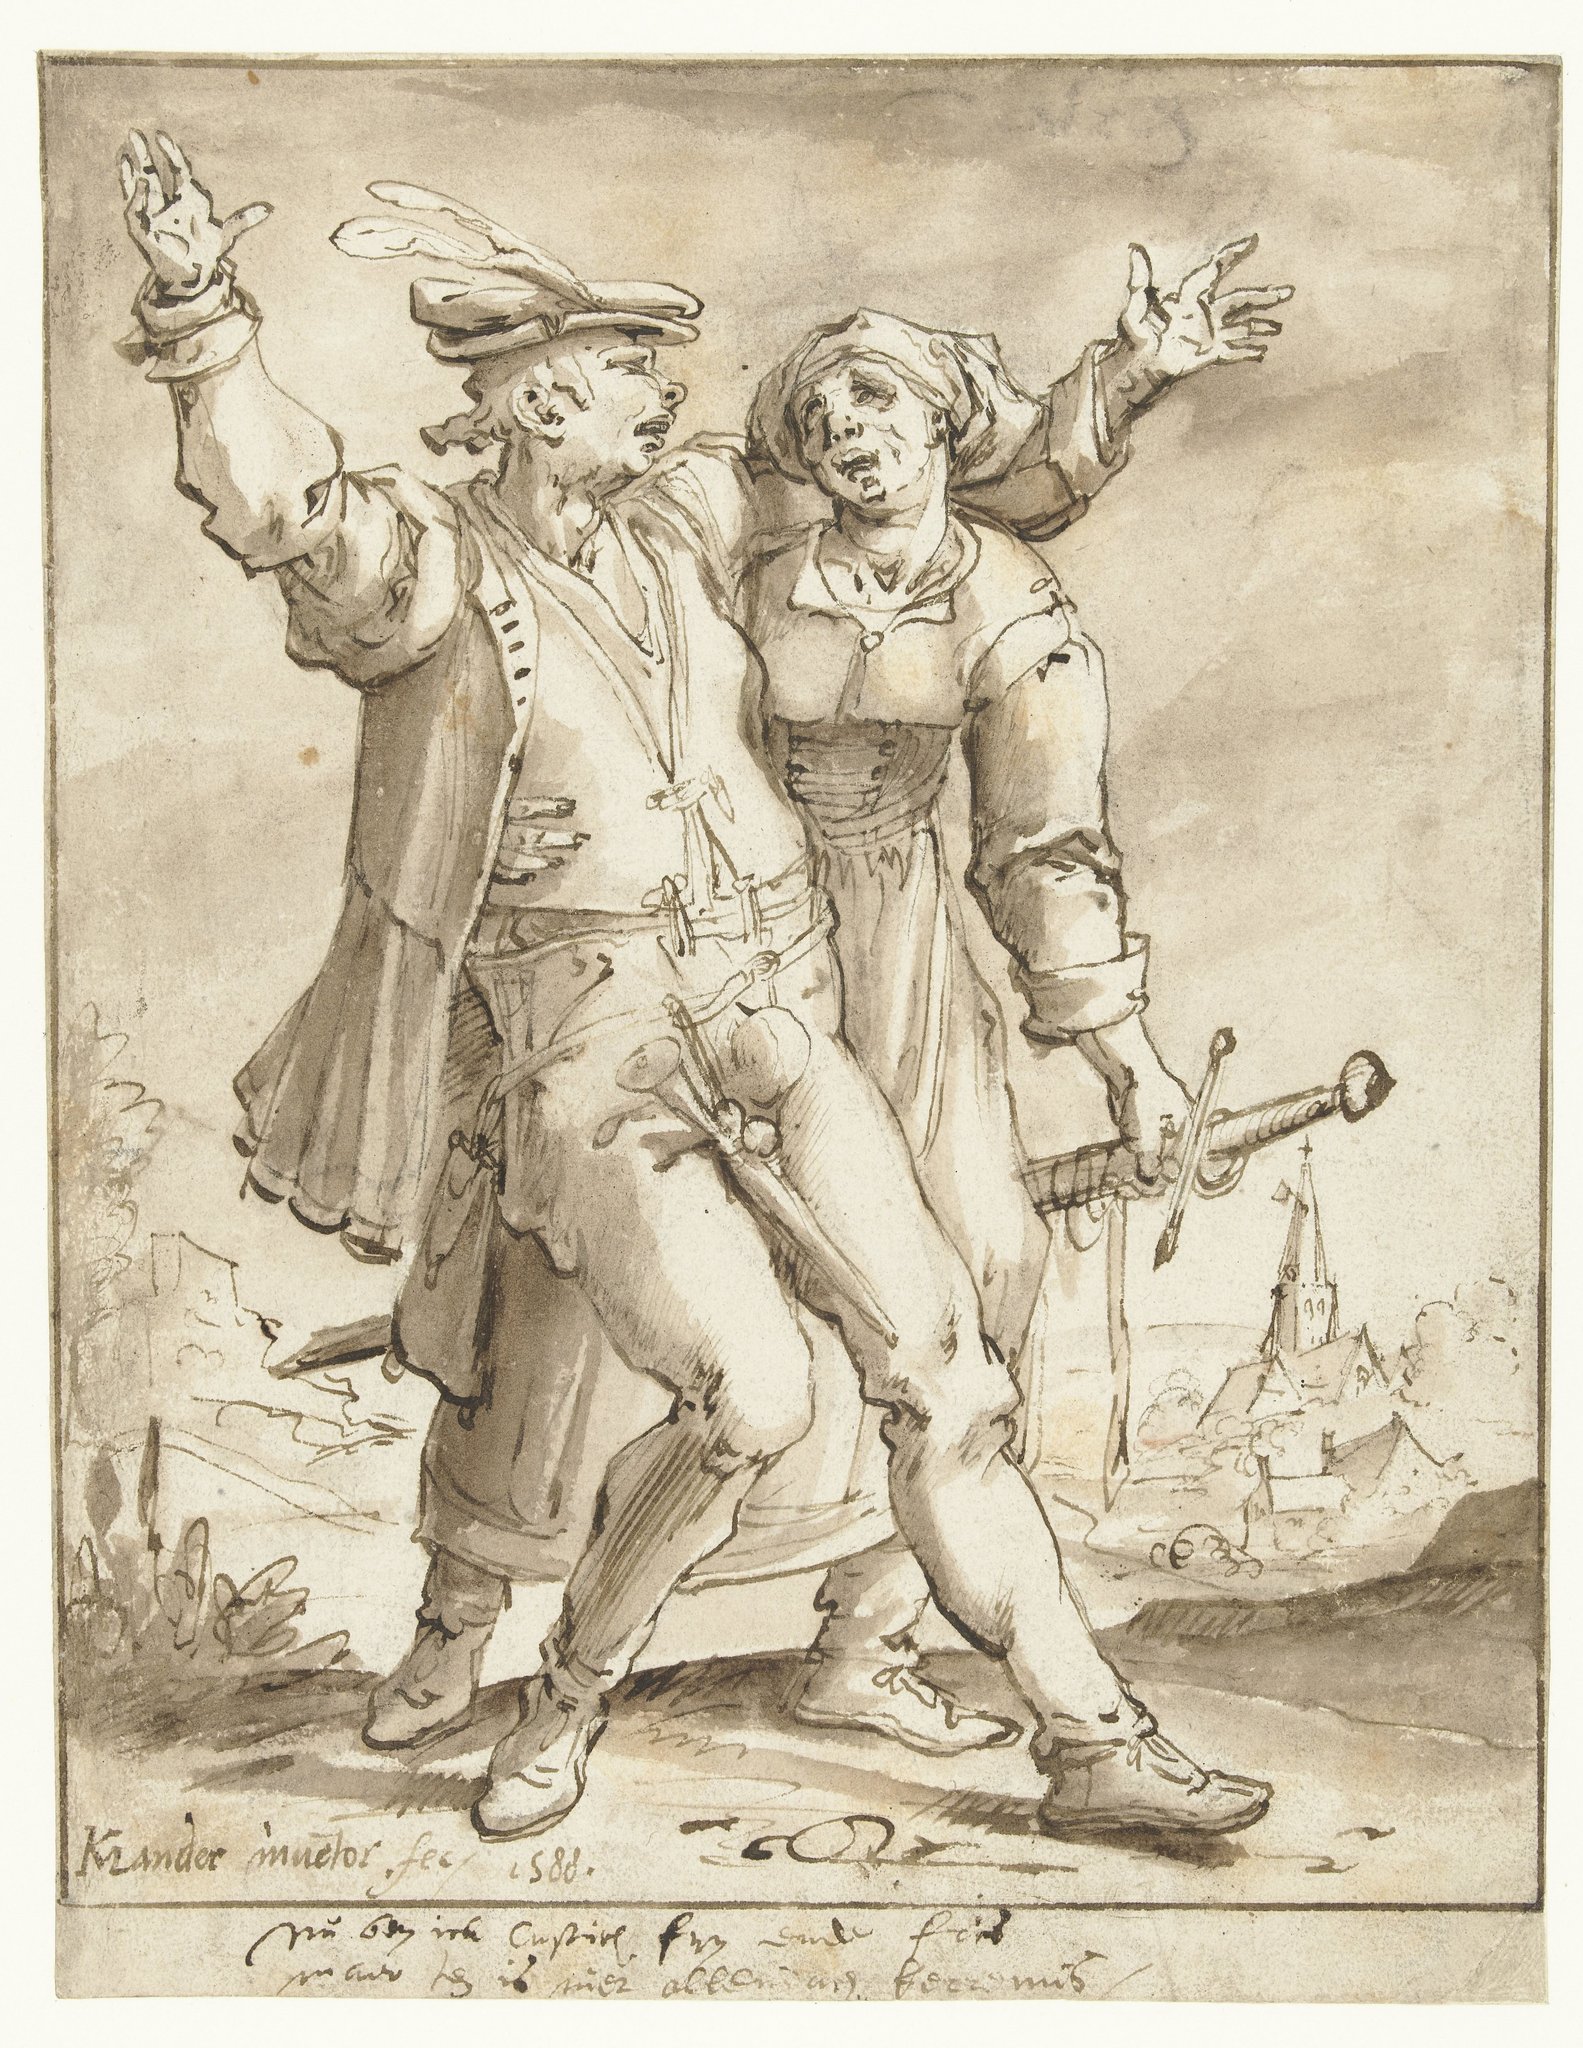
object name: drawing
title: Dronken soldaat vergezeld door een vrouw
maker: karel van mander (i)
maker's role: draughtsman, painter, print maker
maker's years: 1548-1606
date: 1588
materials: ink, paper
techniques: brush, pen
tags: drunkard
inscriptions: date